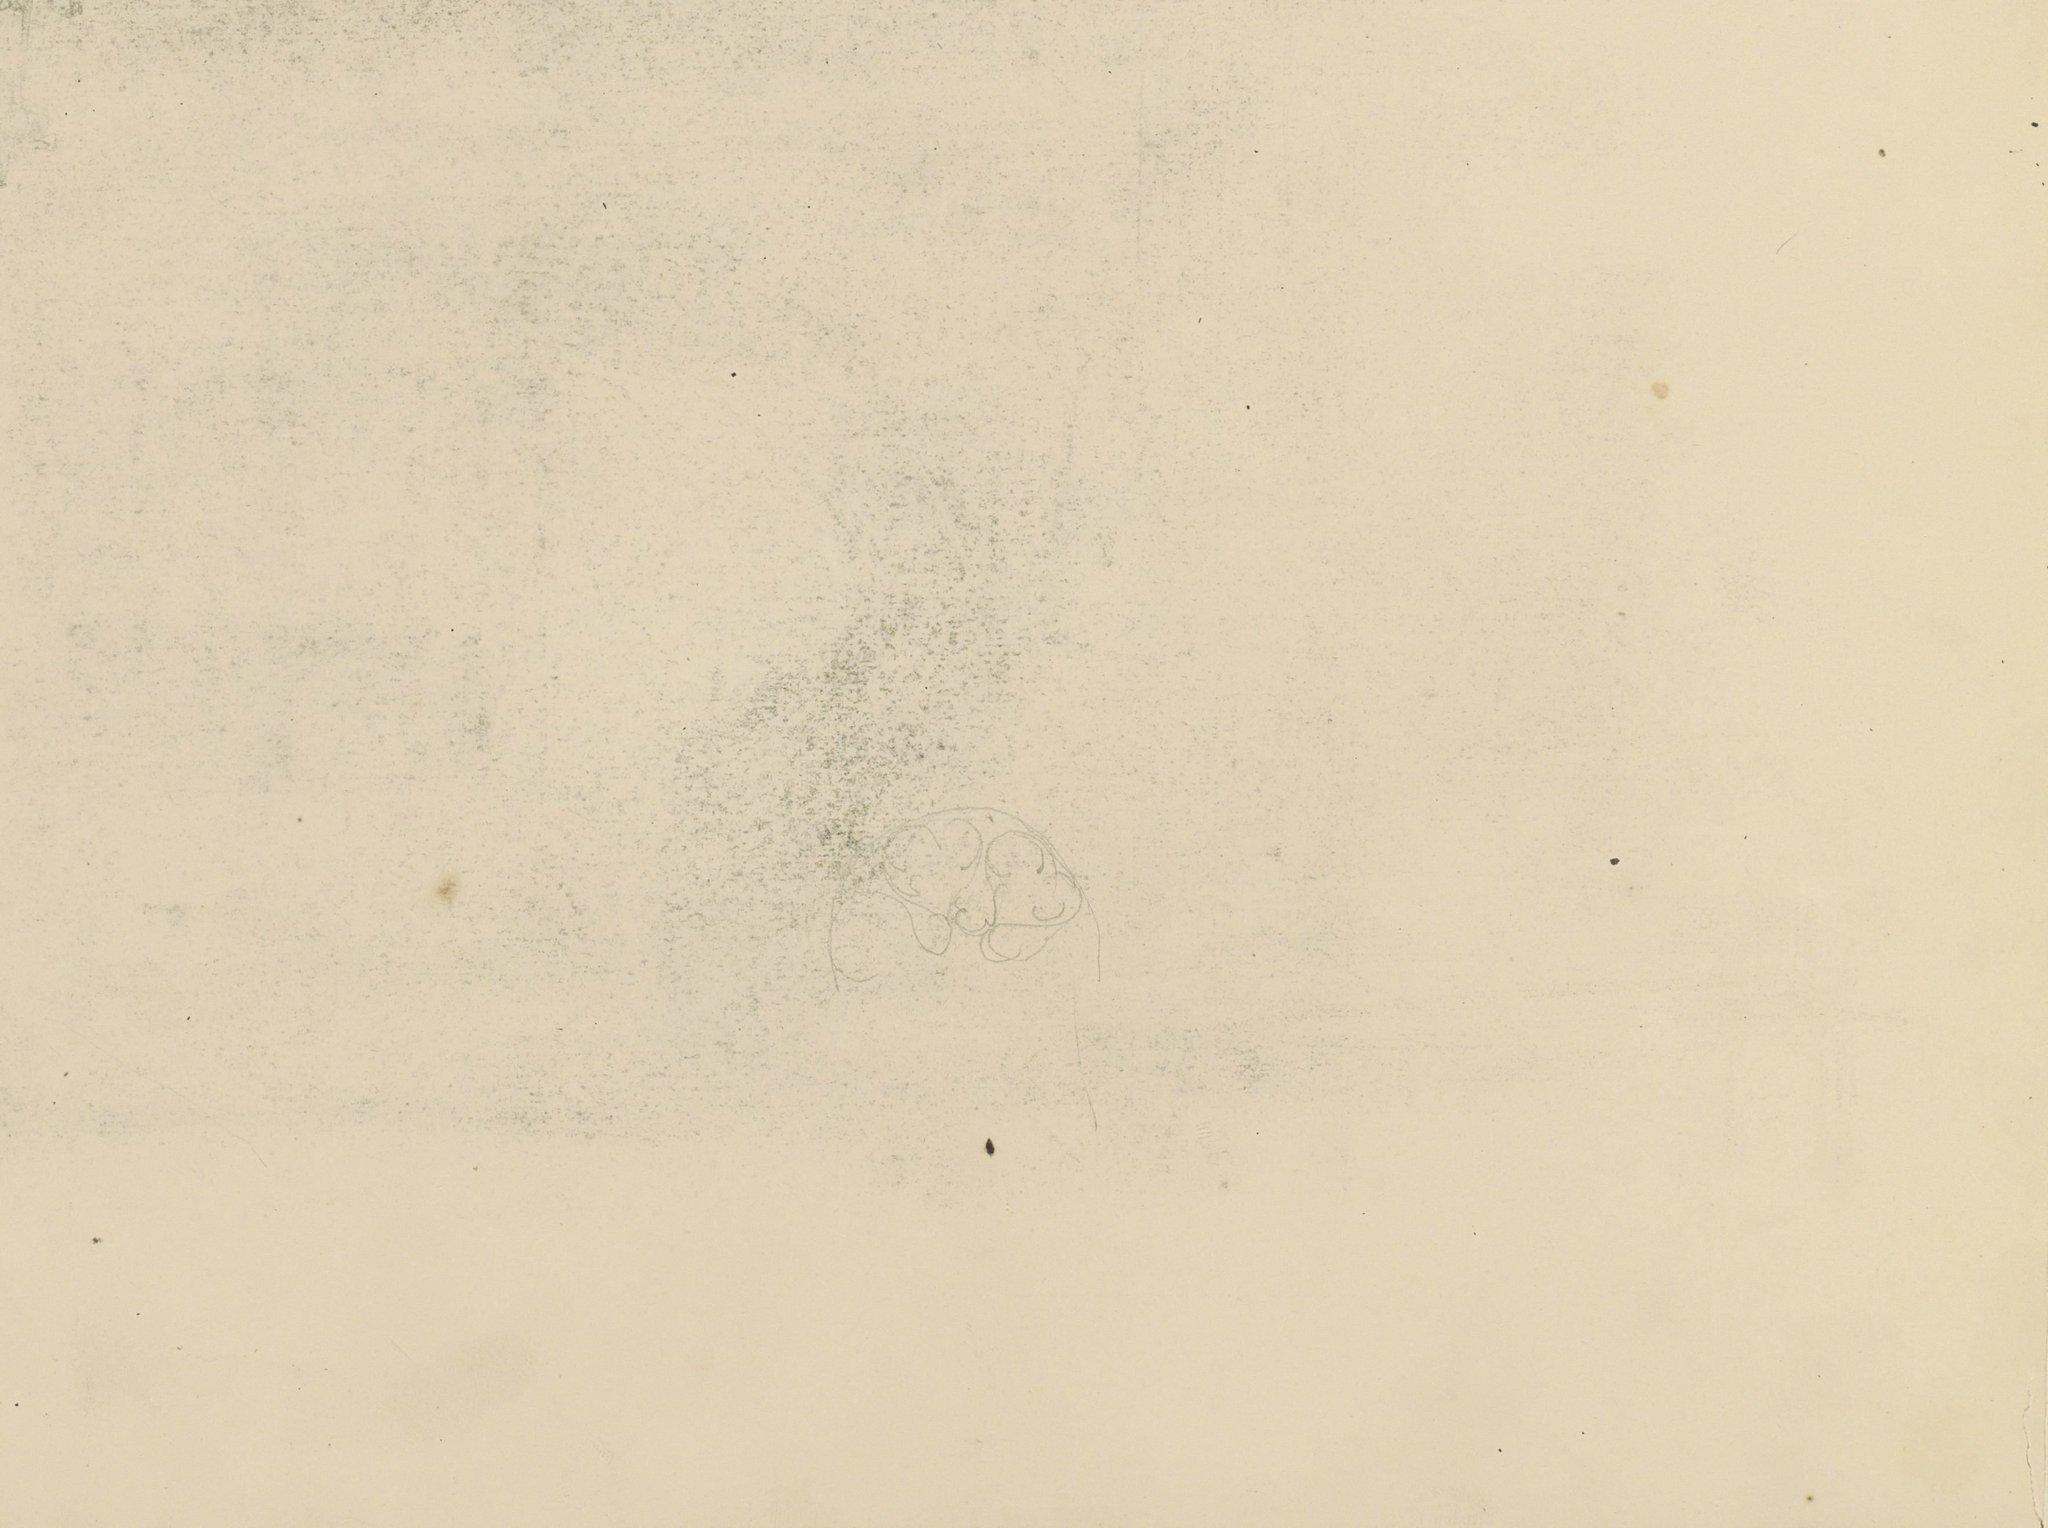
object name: sketchbook leaf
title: Maaswerk en een altaar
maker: pierre joseph hubert cuypers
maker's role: draughtsman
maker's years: 1827-1921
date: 1850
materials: paper, pencil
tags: ornament ~ tracery, altar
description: Blad 5 verso uit een schetsboek met 37 bladen.